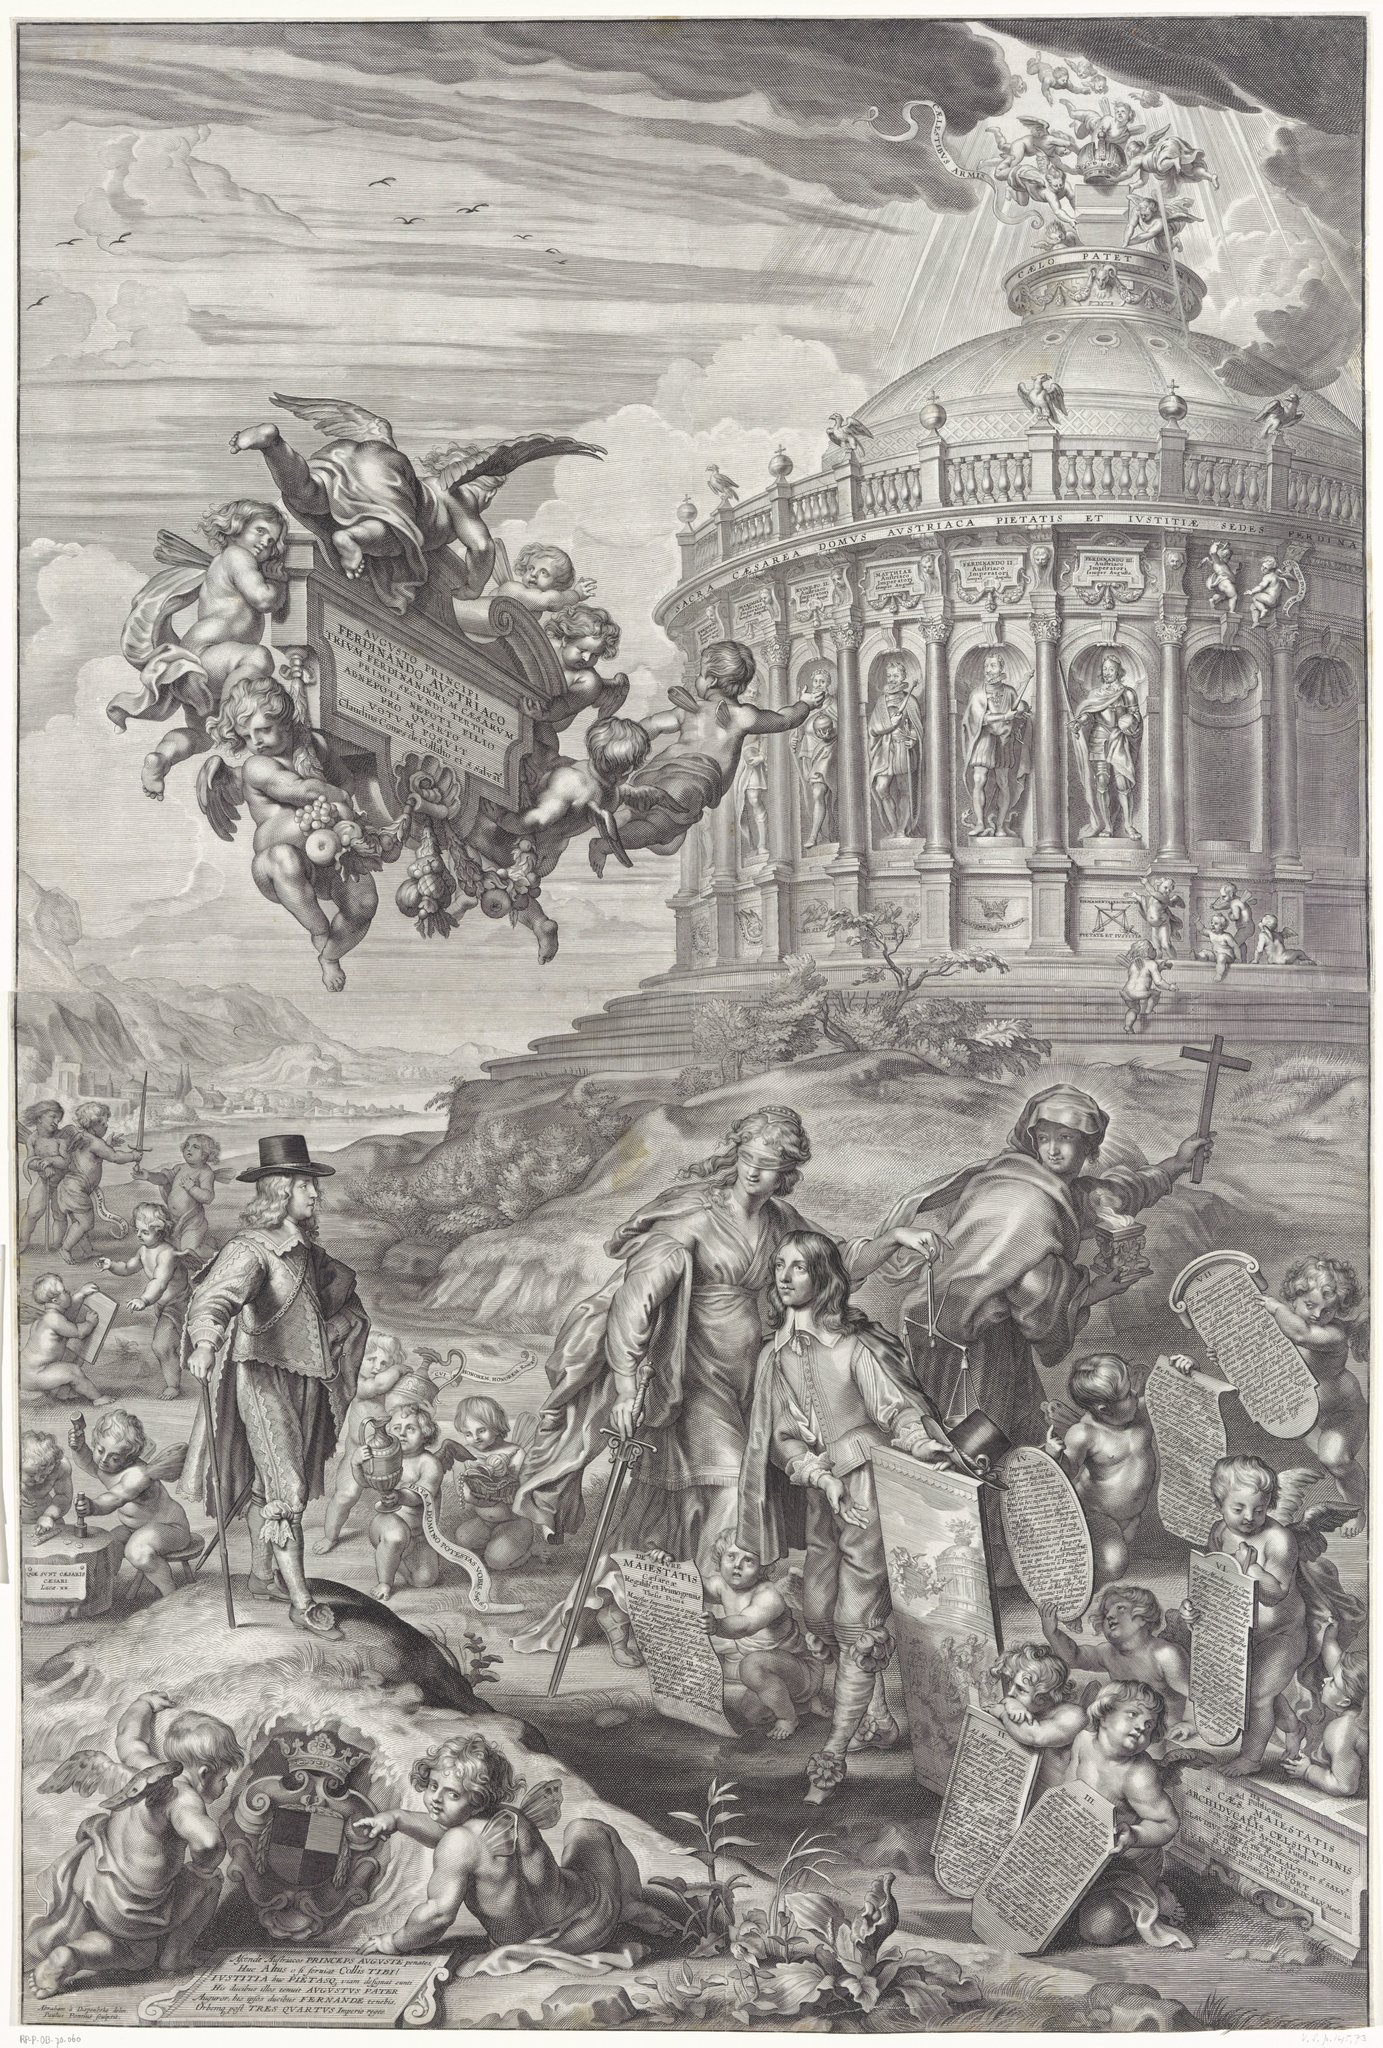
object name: promotieprent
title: Promotieprent van Claudius von Collalto, 1645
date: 1645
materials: paper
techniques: engraving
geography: antwerp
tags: matthias van oostenrijk (rooms-duits keizer), ferdinand iii (duits keizer), vienna, ferdinand ii (duits keizer), maximiliaan ii (keizer van heilige roomse rijk), prague, rudolf ii van habsburg (duits keizer), crown (symbol of sovereignty), justice, 'justitia'; 'giustitia divina' (ripa) ~ one of the four cardinal virtues, sculptor at work, faith, 'fides'; 'fede', 'fede catholica', 'fede christiana', 'fede christiana catholica' (ripa) ~ one of the three theological virtues, angels, armorial bearing, heraldry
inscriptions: date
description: Aankondiging van de promotie van Claudius von Collalto en de verdediging van zijn proefschrift aan de universiteit van Leuven. Op de voorgrond Rechtvaardigheid en Geloof, vergezeld door putti met tabletten waarop de te verdedigen standpunten in het Latijn. In het midden staat een jonge man met het ontwerp van de promotieprent. Een rijke heer op een heuvel aan de linkerzijde slaat het tafereel gade, putti bieden hem geschenken aan. Achter hem putti die munten slaan, tekenen en vechten met een zwaard. Op de achtergrond een tempel met standbeelden van aartshertogen van Oostenrijk, tevens keizers van het Heilige Roomse Rijk. In de lucht vliegen engelen, ze dragen een ornament met zich mee waarop een opdracht aan Ferdinand III, aartshertog van Oostenrijk en keizer van het Heilige Roomse Rijk, in het Latijn. Links op de voorgrond twee putti bij het wapenschild van Claudius von Collalto. Rechtsonder op een ornament de aankondiging van de promotie aan de universiteit van Leuven, met professor Jacob van Santvoort als promotor.